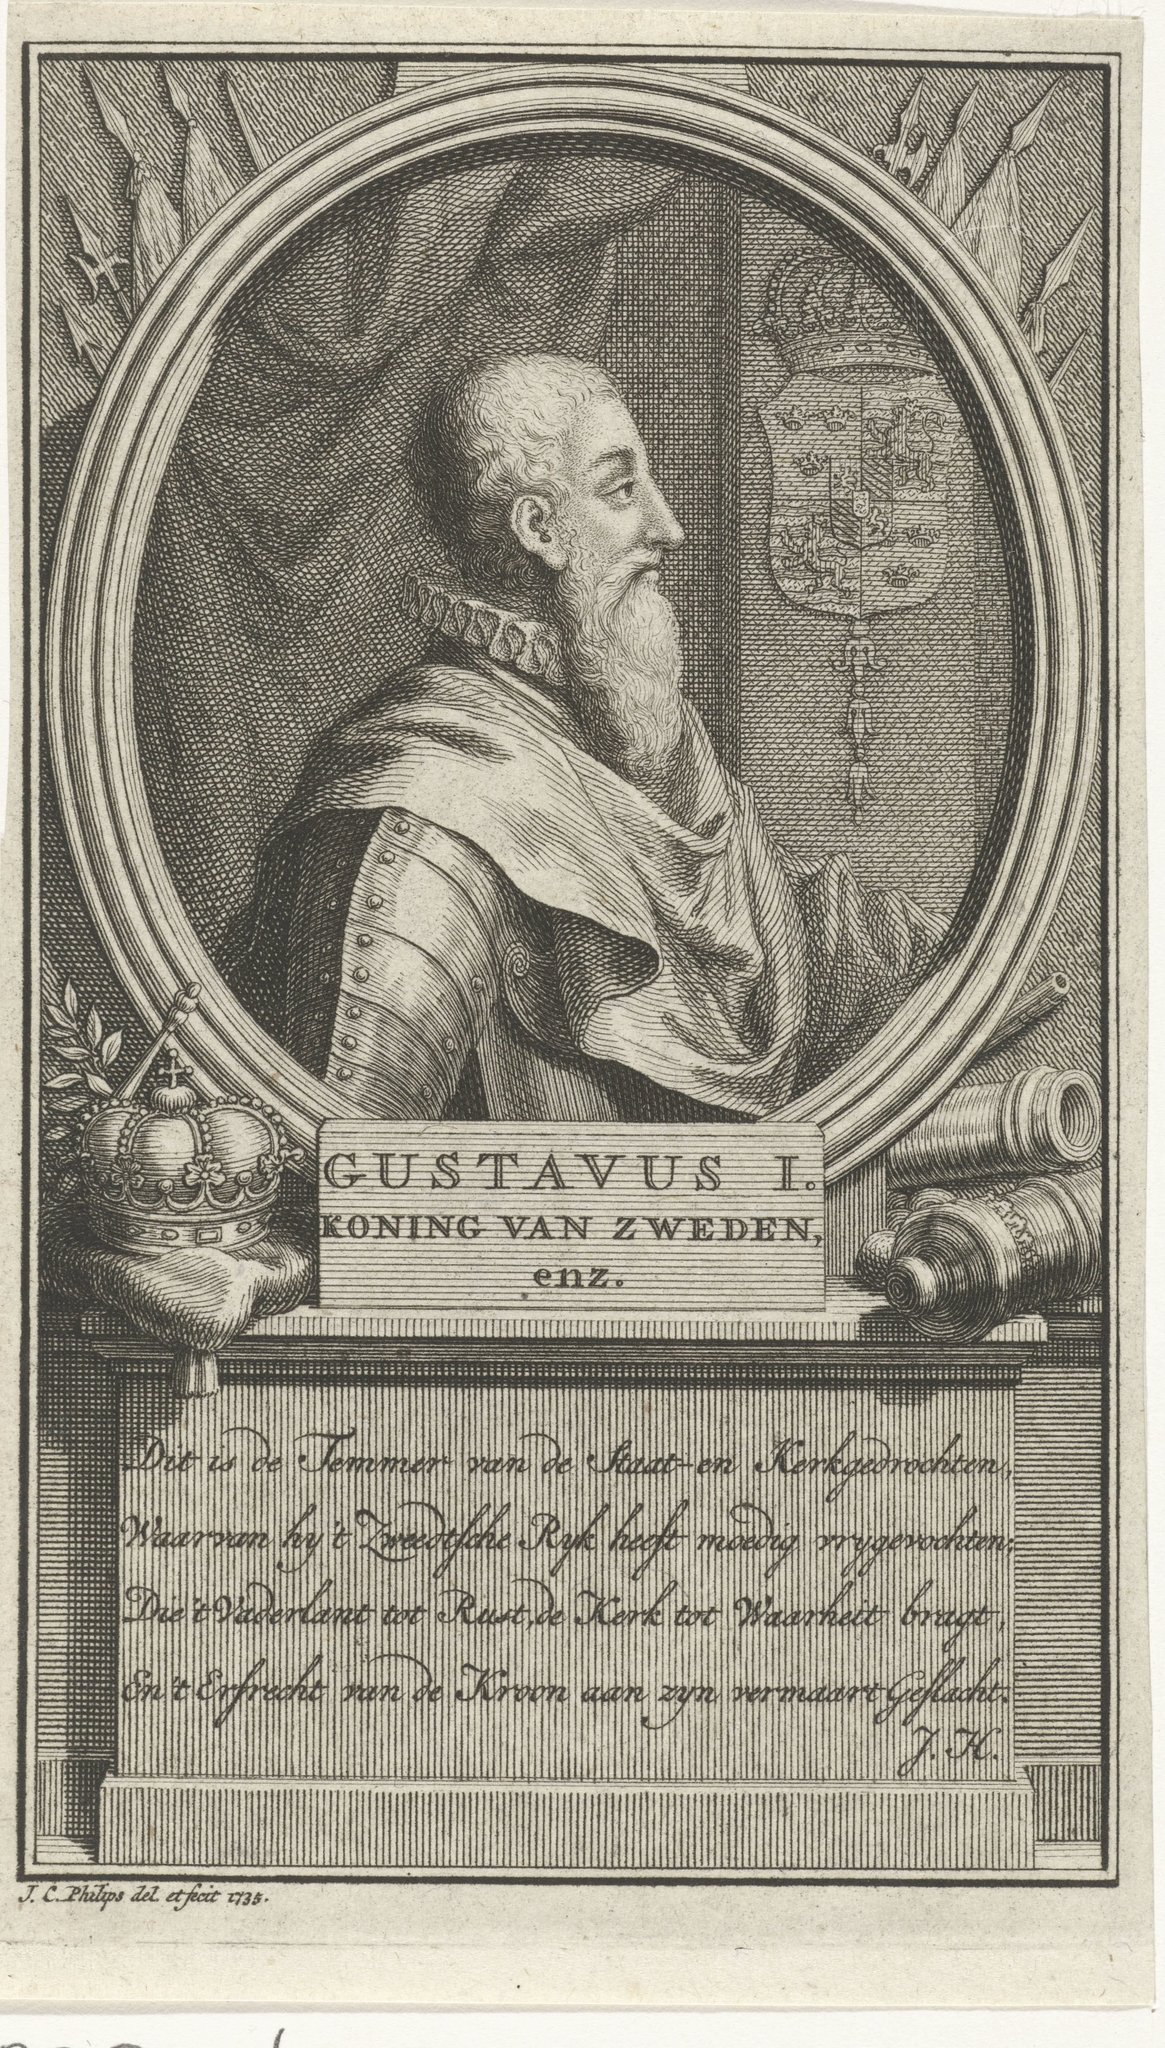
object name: print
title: Portret van Gustaaf I van Zweden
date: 1735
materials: paper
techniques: engraving, etching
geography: amsterdam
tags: coat of arms (symbol of sovereignty), crown (symbol of sovereignty), armour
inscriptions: collector's mark: Lugt 2228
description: Portret van Gustaaf I, koning van Zweden, ernaast zijn wapenschild. In het kader een vierregelig lofdicht in het Nederlands.